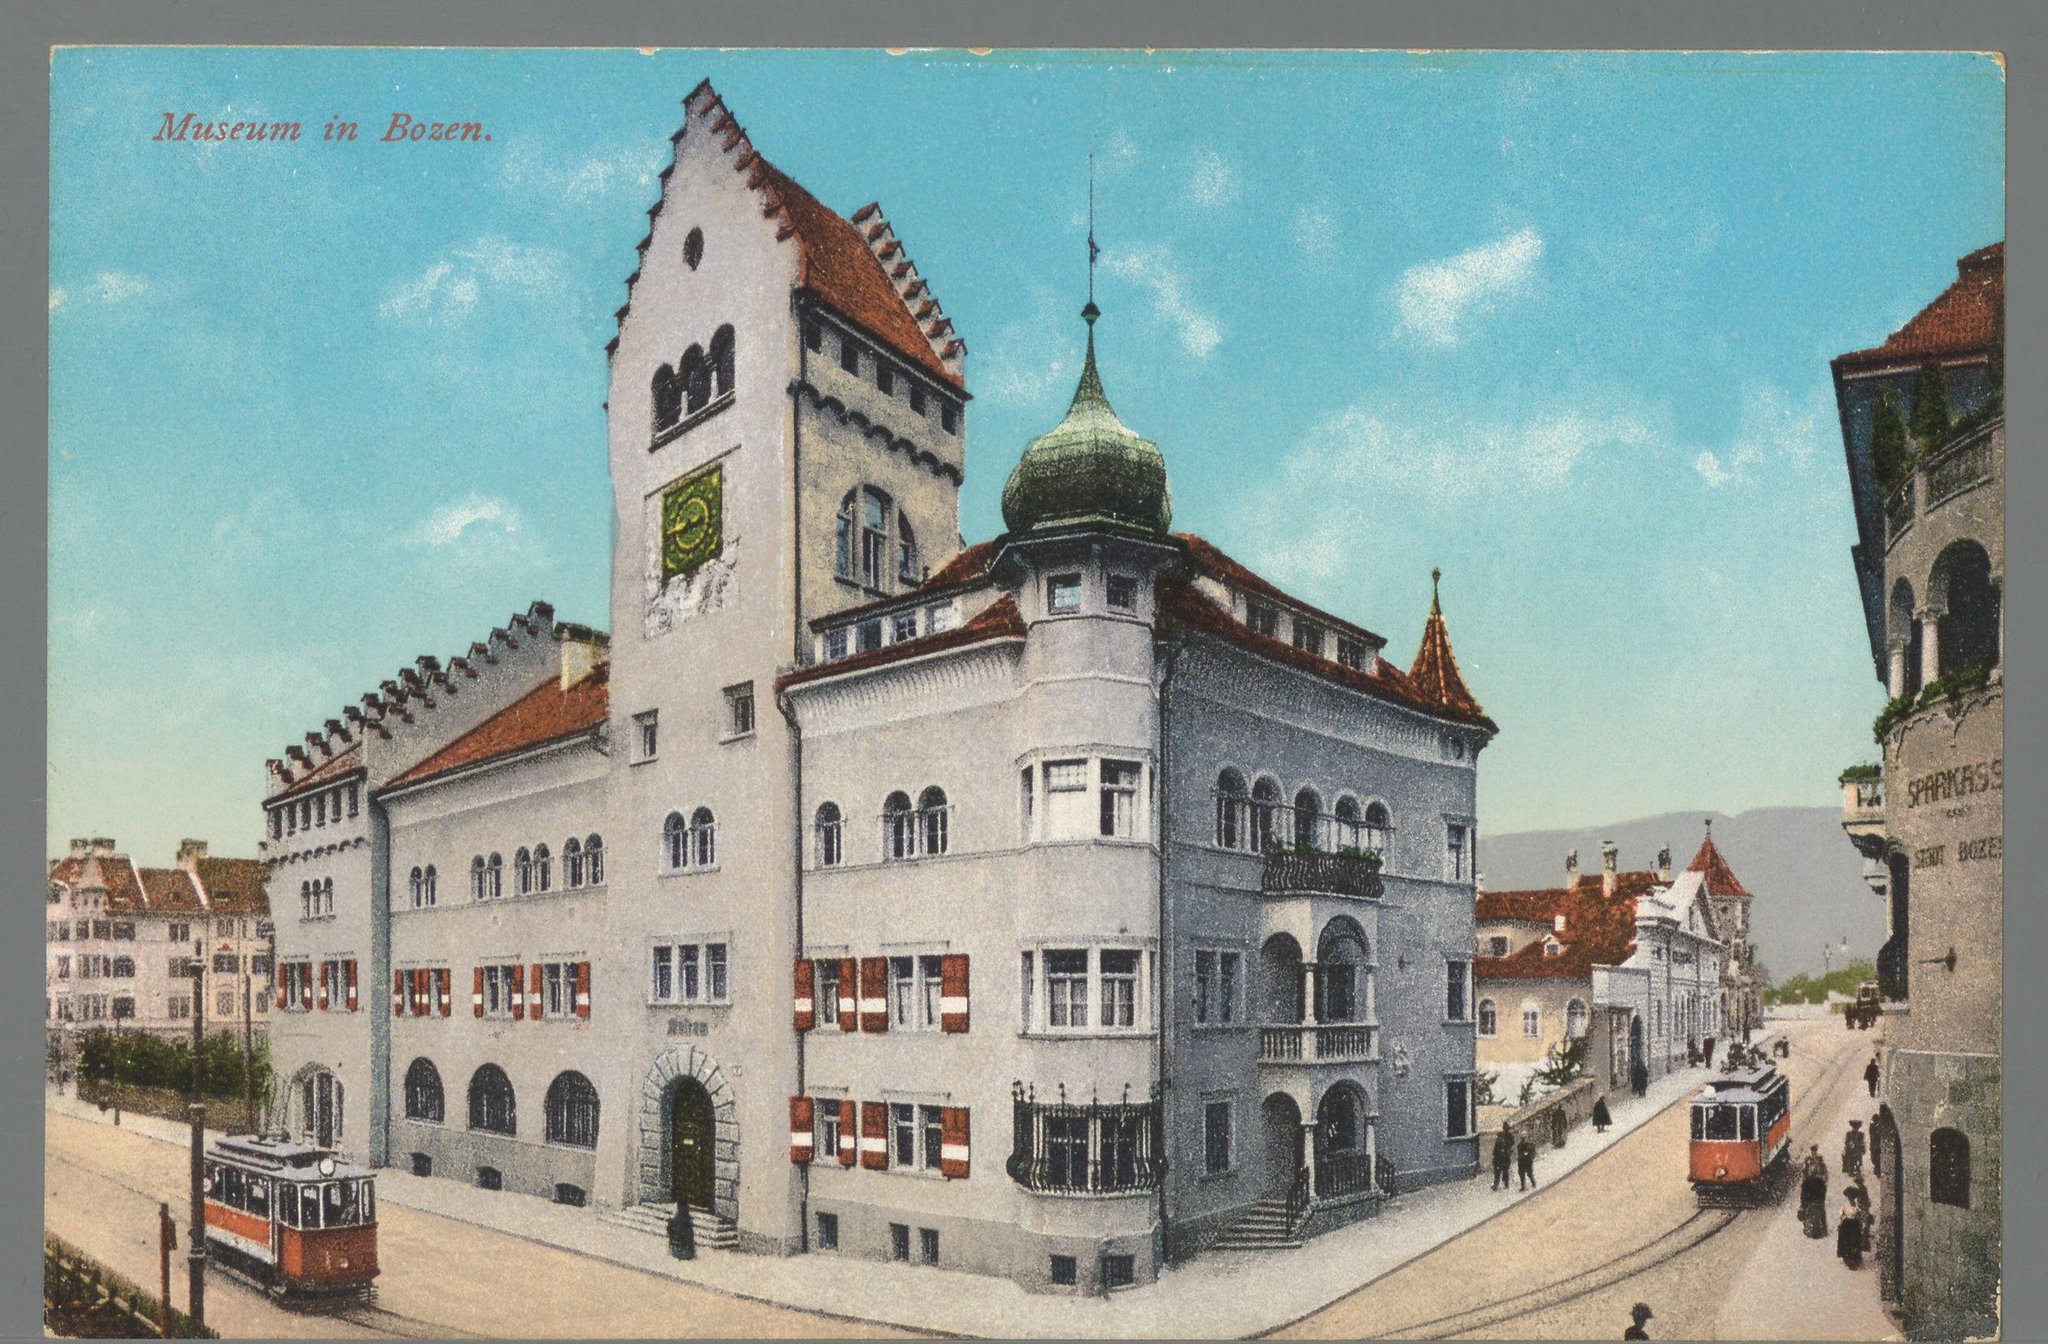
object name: ansichtkaart, prentbriefkaart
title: Museum in Bozen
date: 1906-1930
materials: cardboard, photographic process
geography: bolzano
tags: railway, train, permanent exhibition, museum, city-view, and landscape with man-made constructions (+ city(-scape) with figures, staffage)